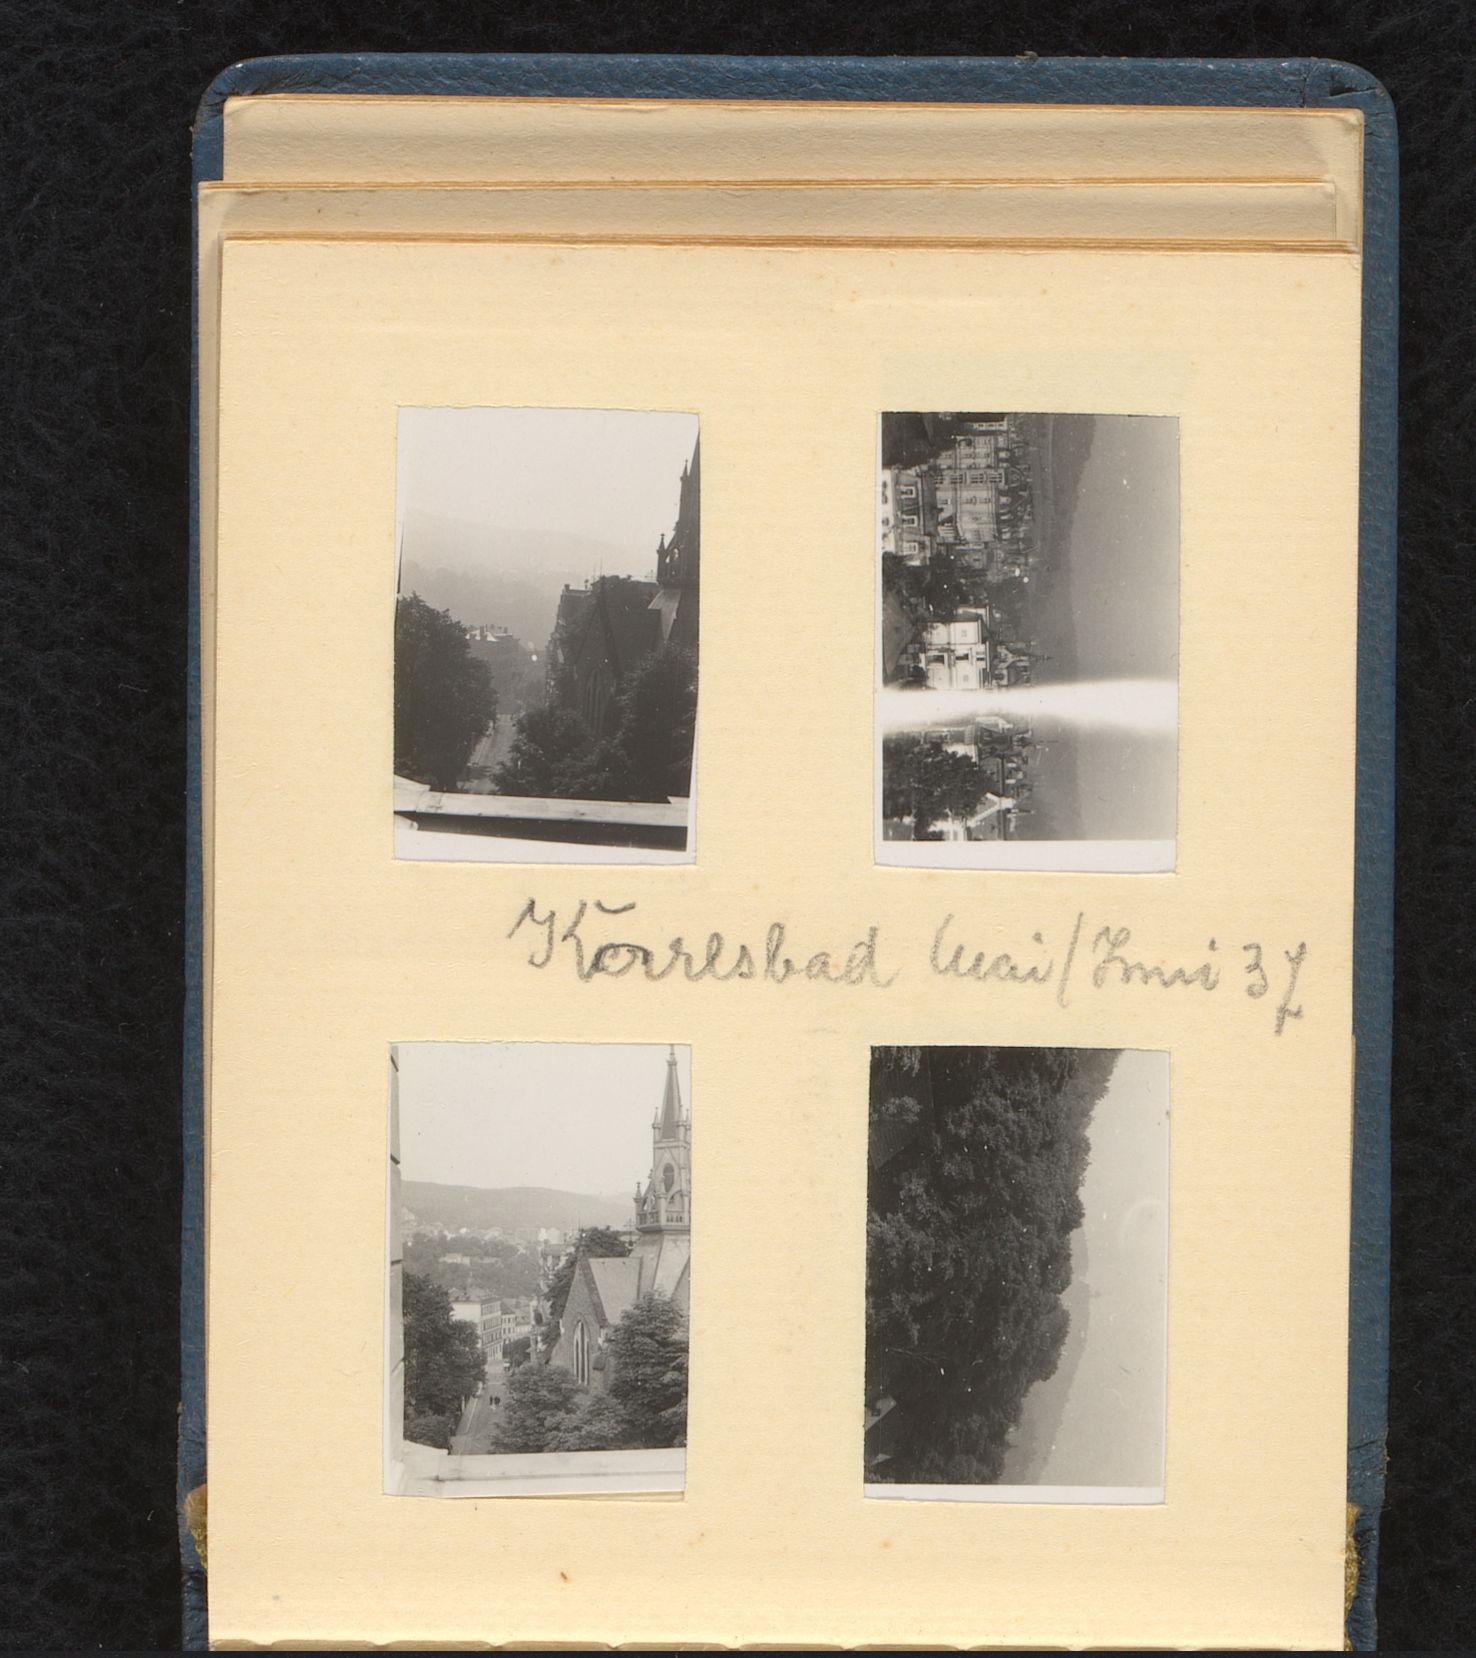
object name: photograph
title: Heuvels rondom Karlsbad, mei-juni 1937, Karlsbad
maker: else wachenheimer-moos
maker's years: 1895-1944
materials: paper, photographic support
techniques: gelatin silver print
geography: karlsbad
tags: the family travelling, on holiday, mountains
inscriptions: inscription: ‘Karlsbad Mai/Juni 37’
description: Albumblad bevat vier foto's. Zonder personen gerelateerd aan de familie Wachenheimer. Uit klein formaat fotoalbum, blauw lederen omslag met drukknopsluiting. Met foto's in klein formaat.